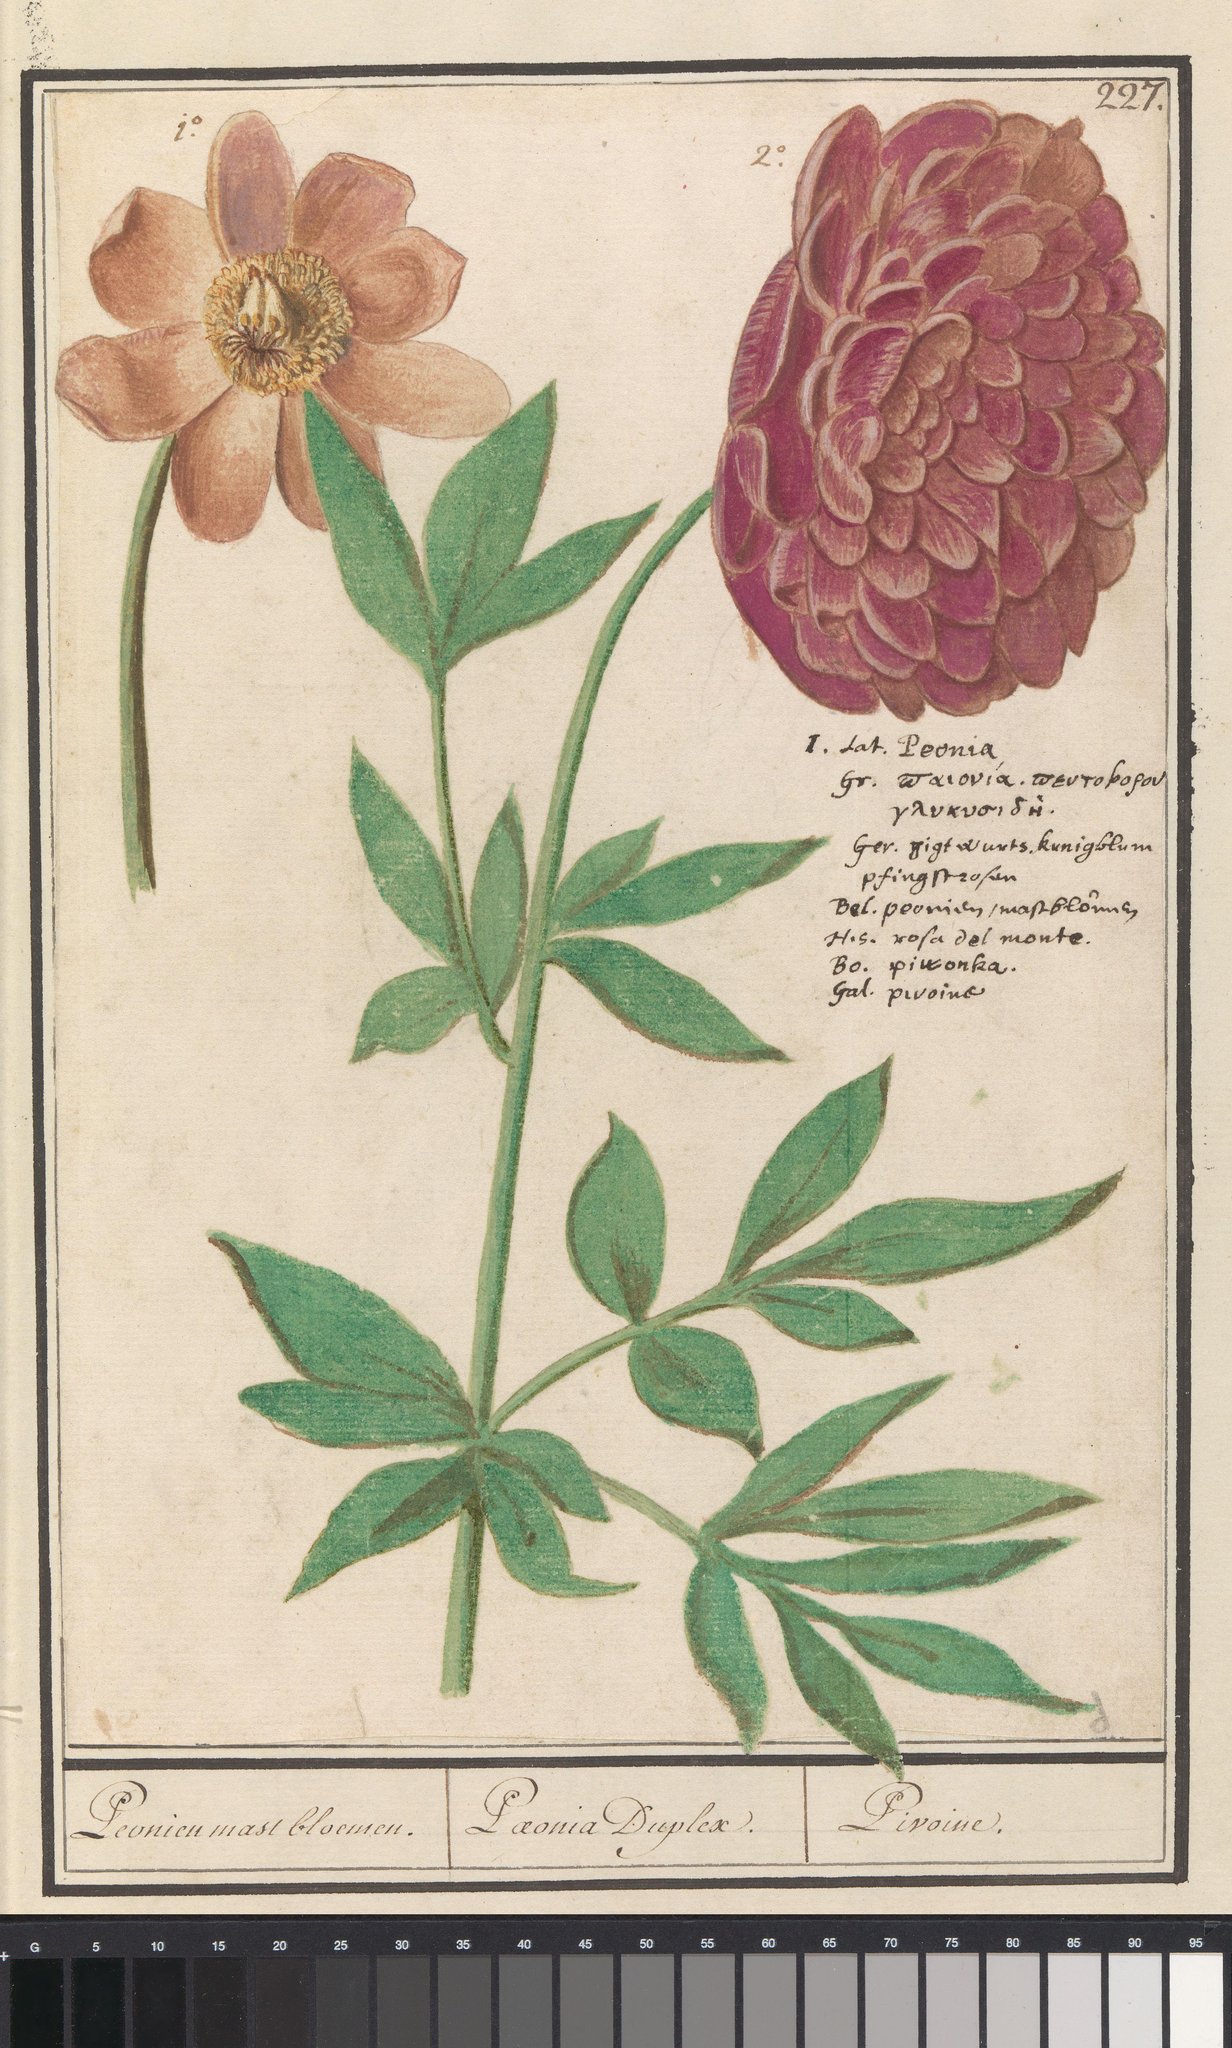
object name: drawing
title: Pioenroos (Paeonia)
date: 1596-1610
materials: chalk, paint, ink, paper, watercolor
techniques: brush, pen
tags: flowers: peony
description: Pioenrozen. Genummerd rechtsboven: 227. Rechts de naam in zeven talen. Onderdeel van het derde album met tekeningen van bloemen en planten. Tiende van twaalf albums met tekeningen van dieren, vogels en planten bekend rond 1600, gemaakt in opdracht van keizer Rudolf II. Met toelichting in Nederlands, Latijn en Frans.